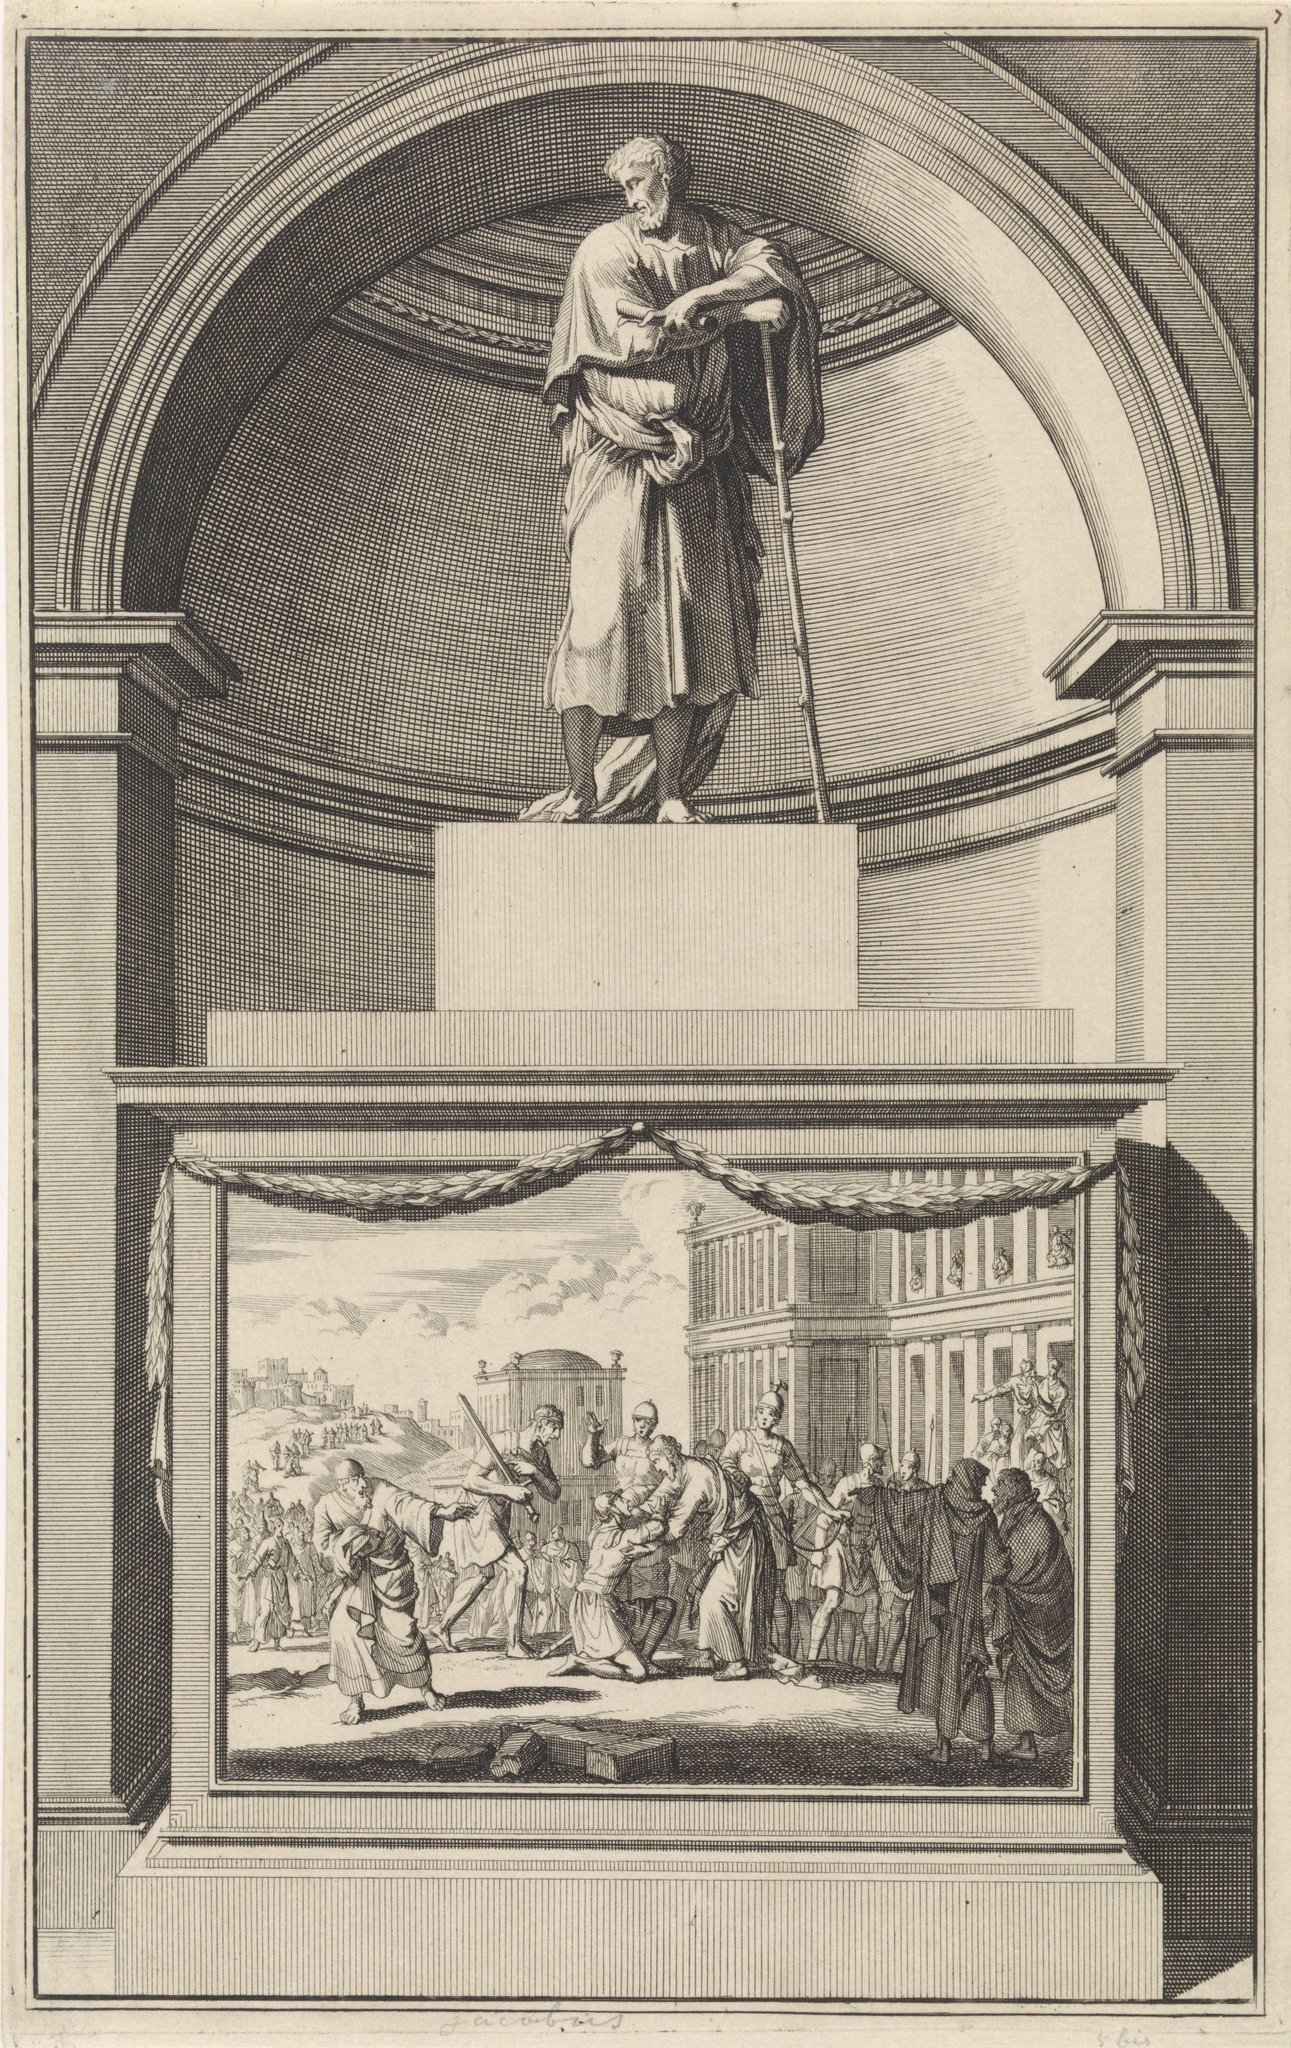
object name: print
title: Apostel Jakobus de Meerdere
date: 1698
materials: paper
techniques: engraving, etching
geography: amsterdam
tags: beheading of james, the apostle james the great; possible attributes: book, pilgrim's cloak, hat, shell, staff, and wallet, scroll, sword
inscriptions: collector's mark: Lugt 2228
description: Proefdruk van illustratie uit: Cave, William. Apostolische oudheden, of Het leven (...) der heylige apostelen, 3 delen. Utrecht: François Halma en Willem van de Water (I), 1698, p. 279.